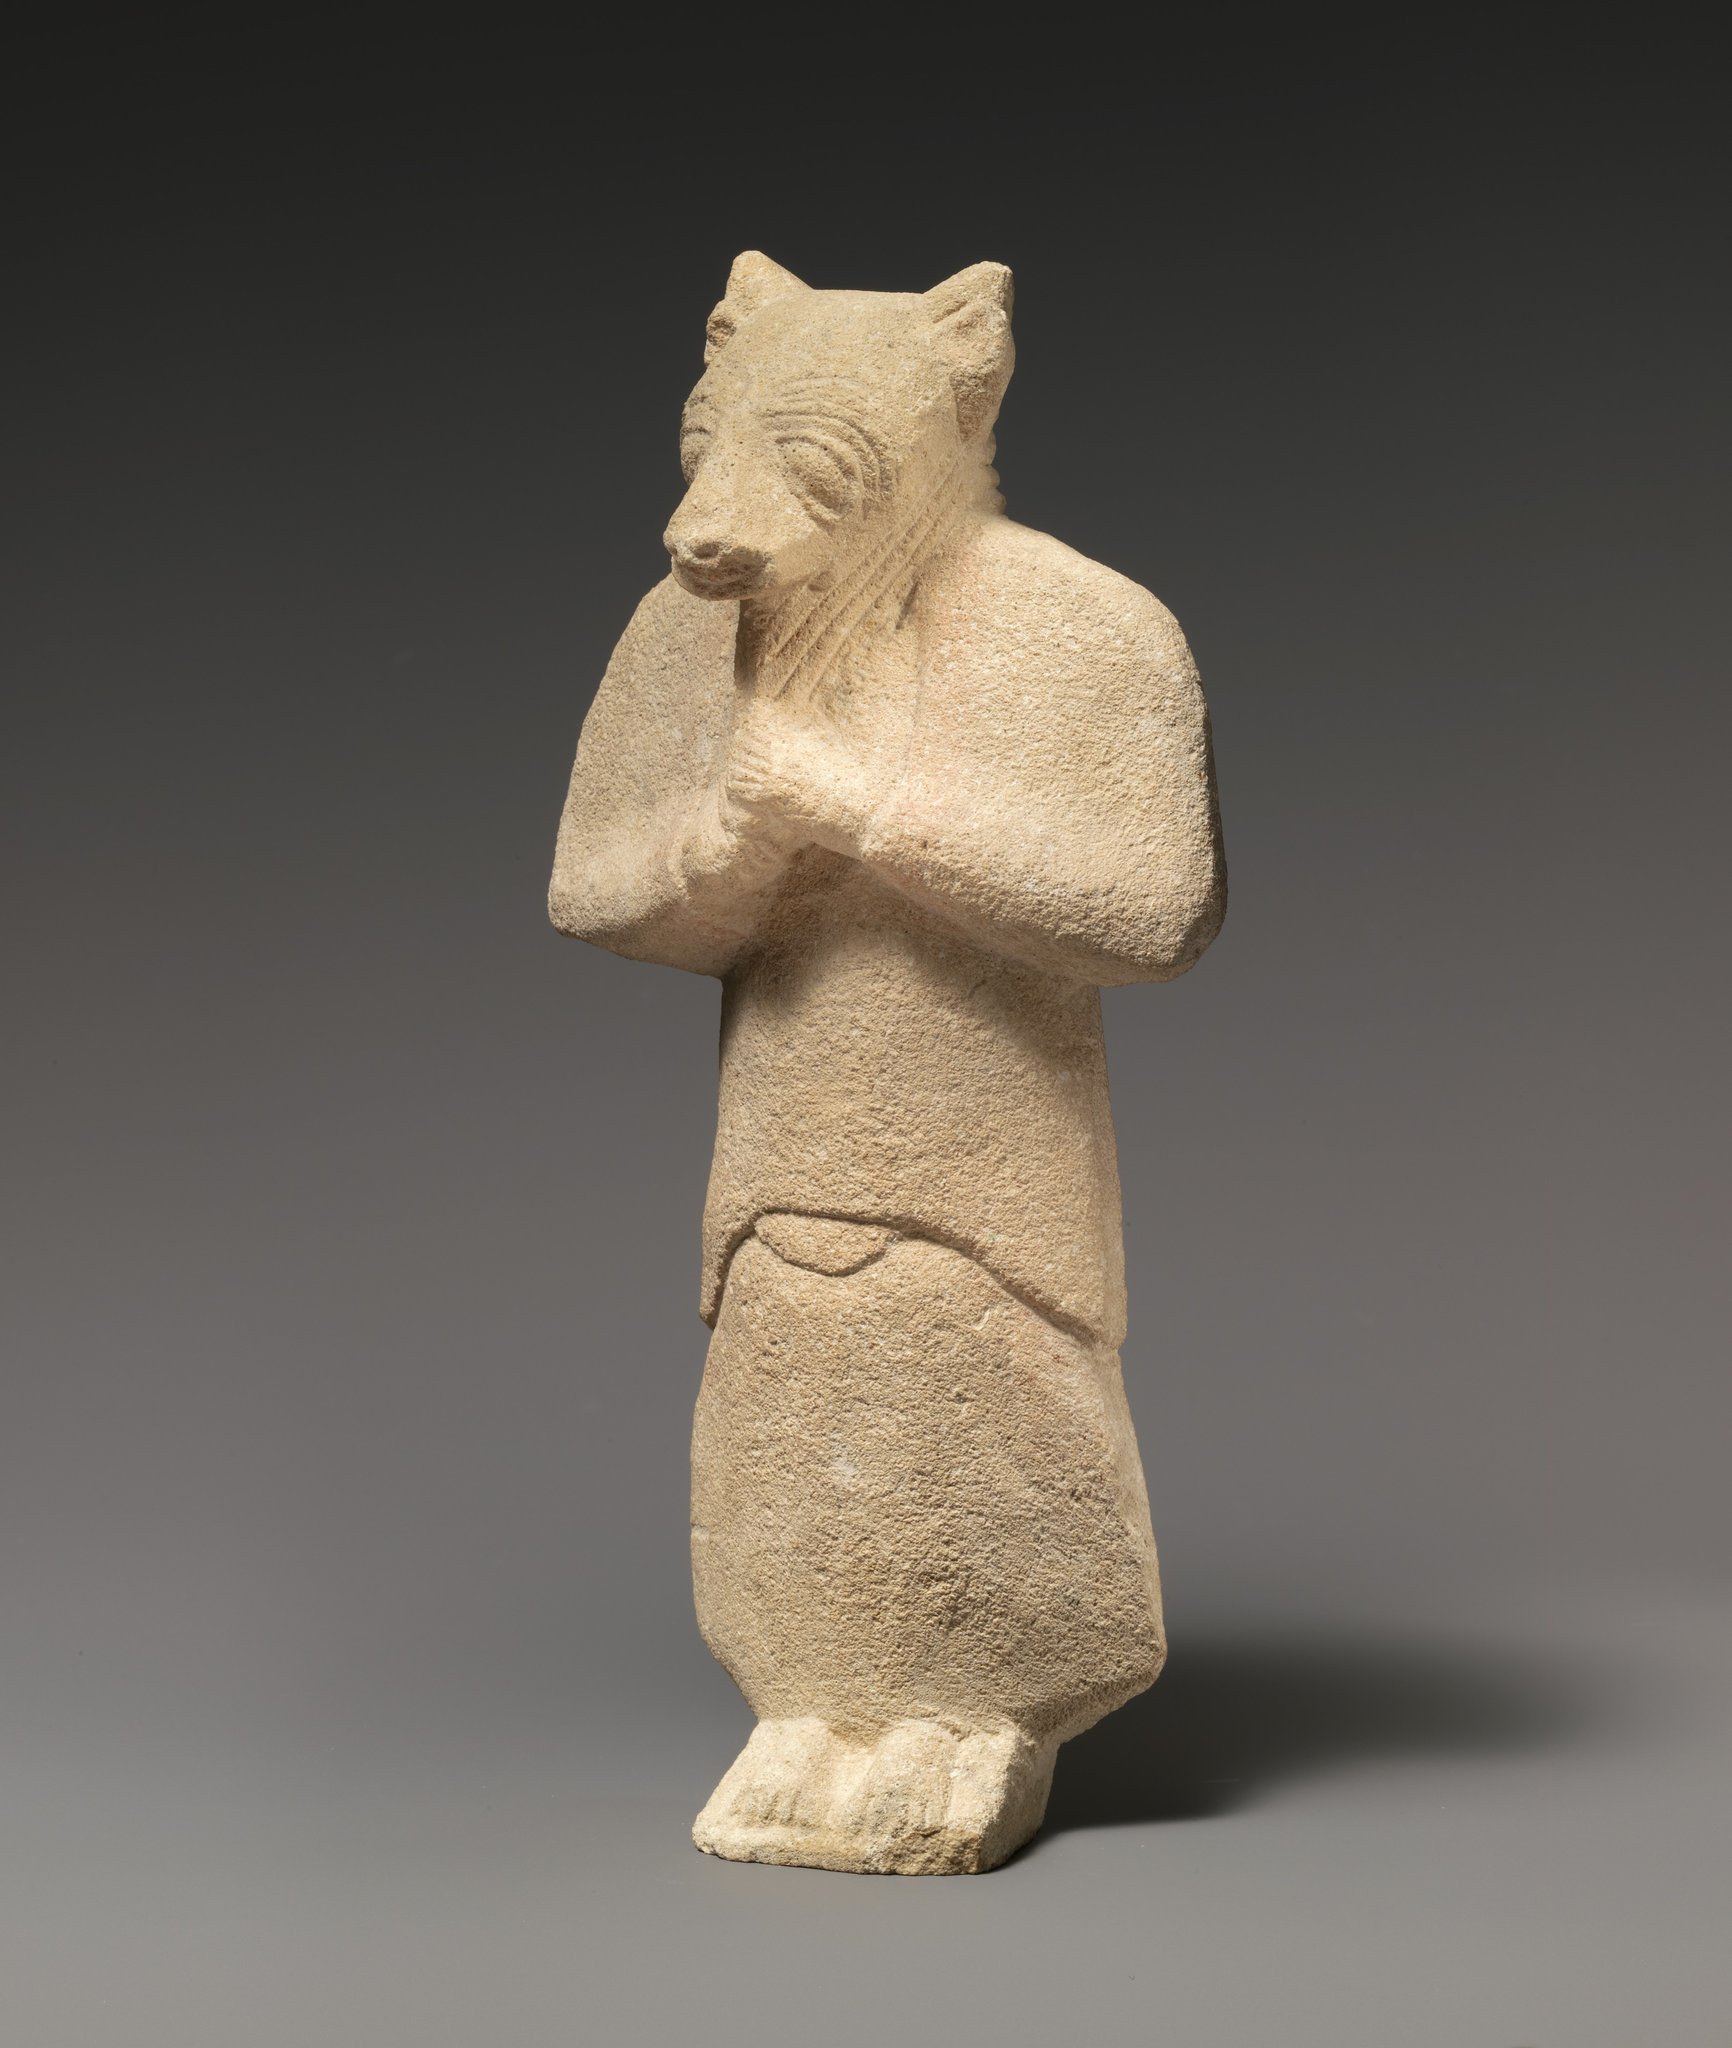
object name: statuette of a priest wearing bull mask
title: Limestone figure wearing a mask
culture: cypriot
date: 575-551 BCE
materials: limestone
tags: human figures,masks,bulls